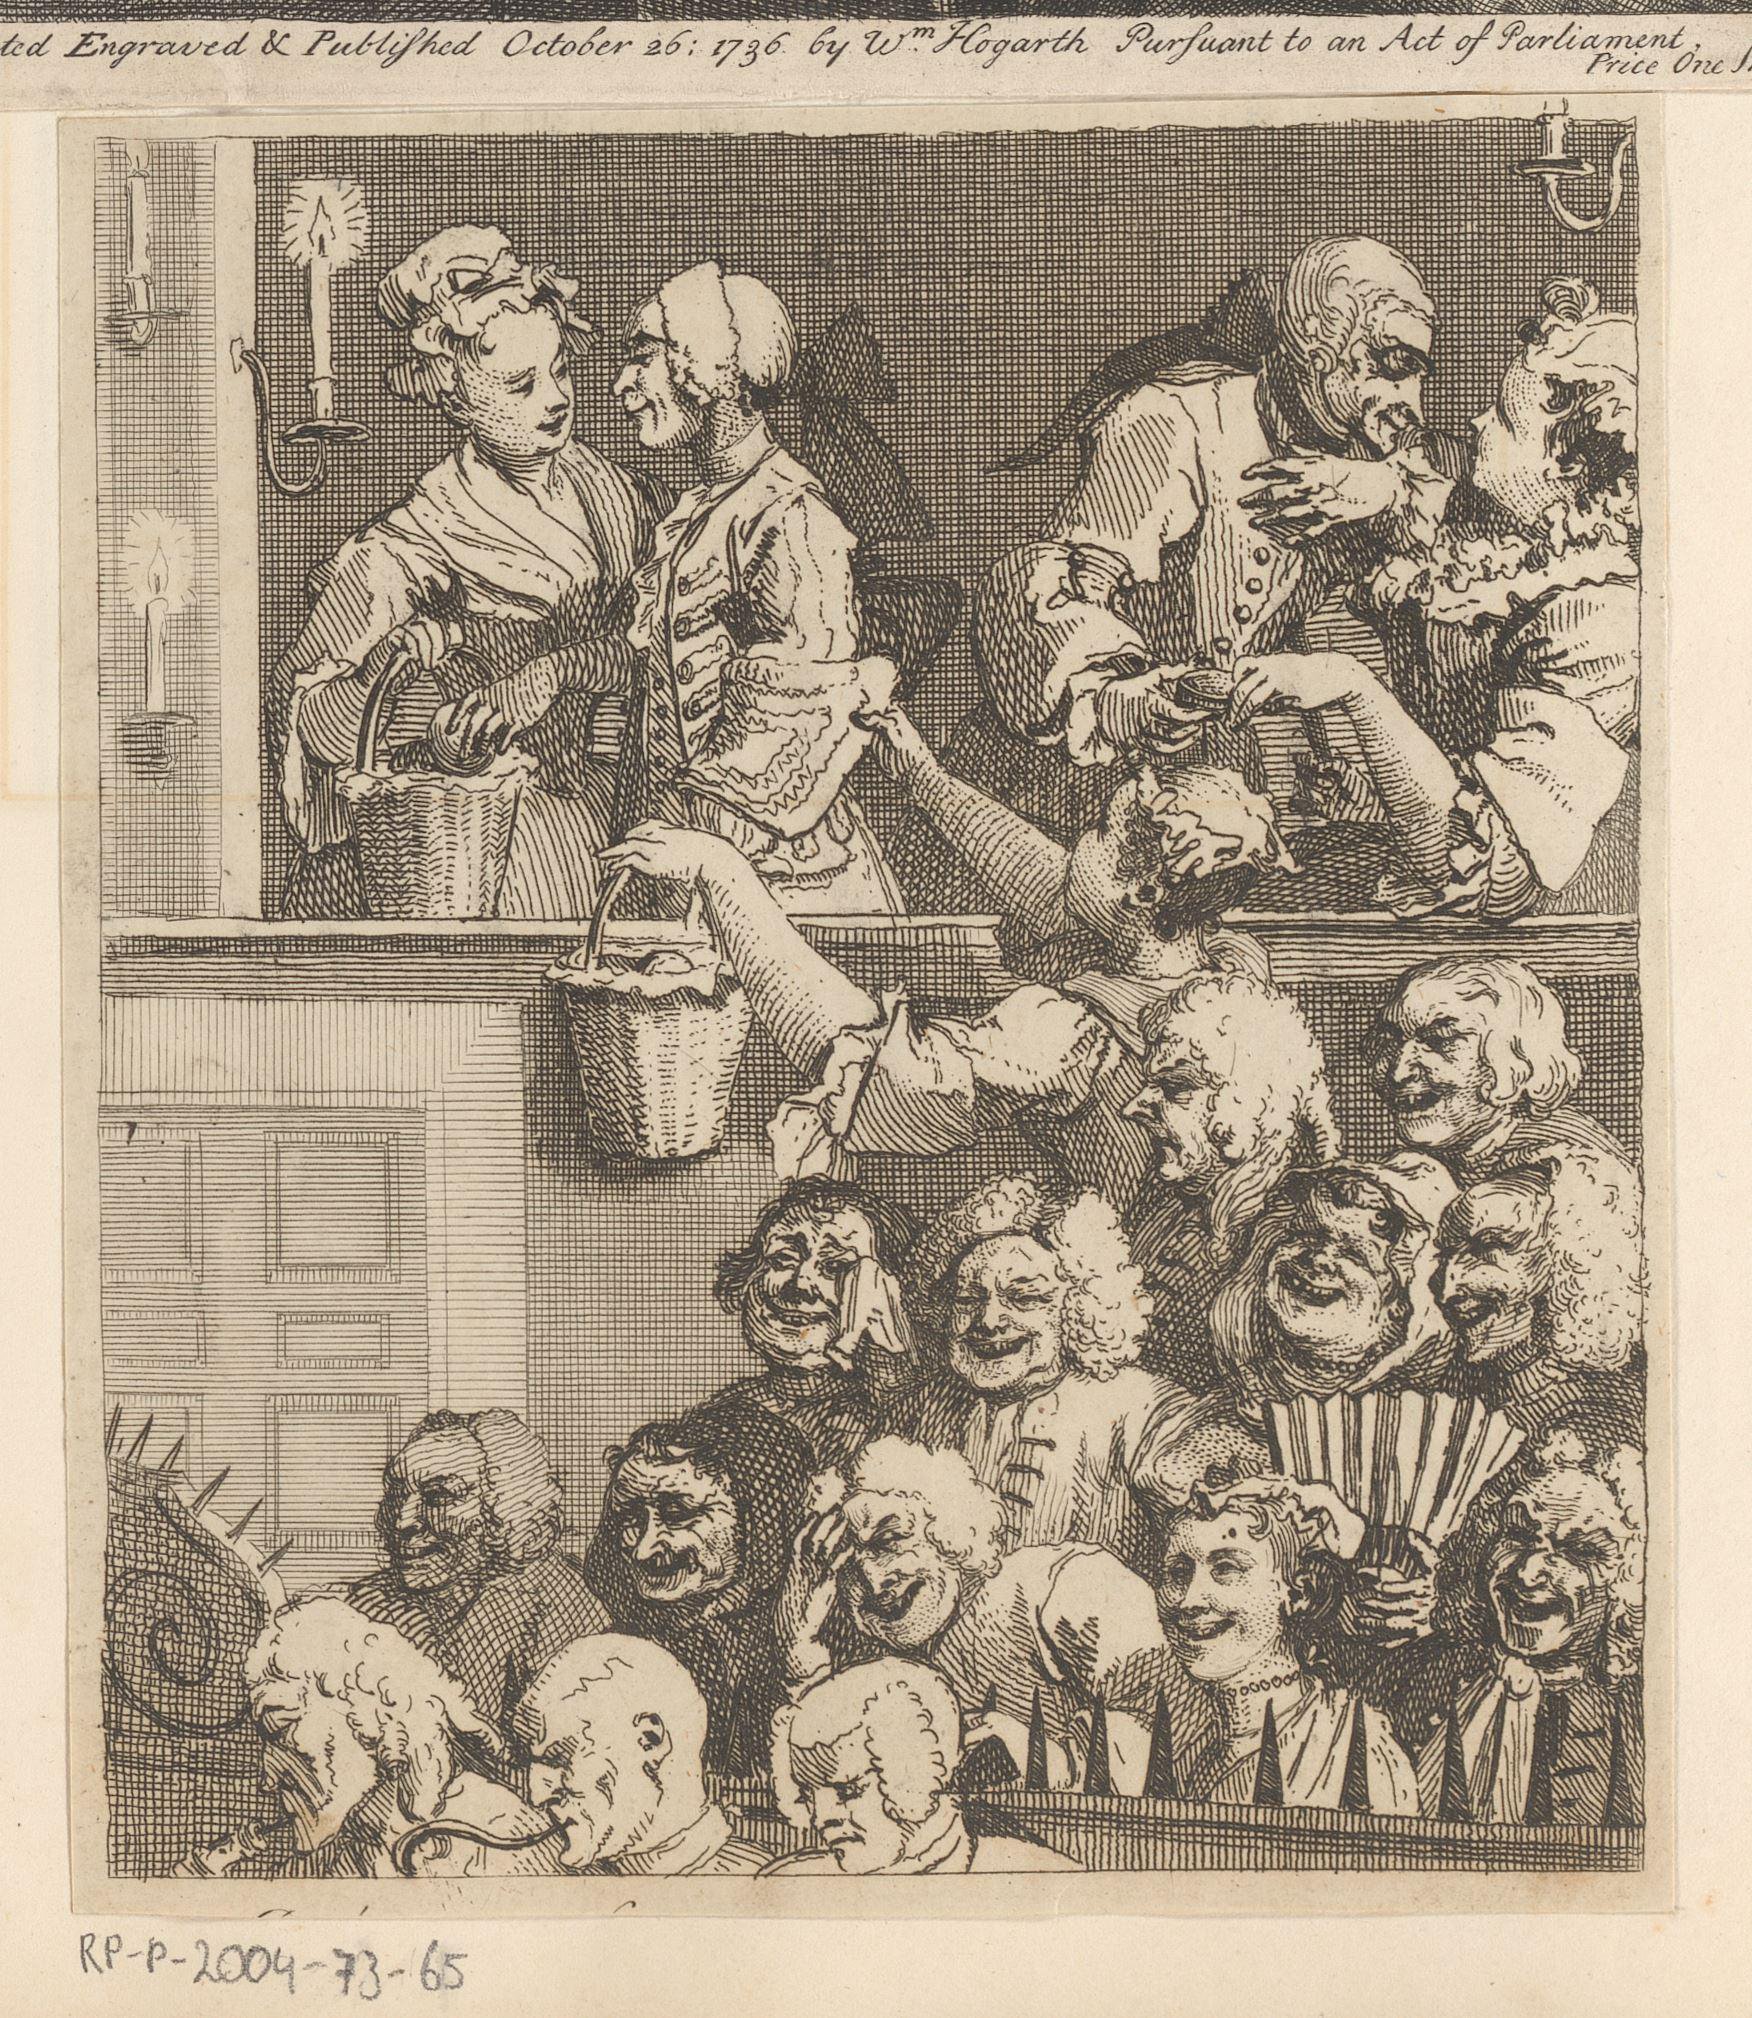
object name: print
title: The Laughing Audience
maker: william hogarth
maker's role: draughtsman, painter, print maker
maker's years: 1697-1764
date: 1733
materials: paper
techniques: etching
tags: laughing, social stratification, social groups, the audience ~ art performance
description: De samensteller heeft deze prent in het album geplakt als illustratie bij: Pilkington, Matthew en Johann Heinrich Füssli. A dictionary of painters, from the revival of the art to the present period. 4 dln. Londen: John Crowder, 1805, dl. 2, p. 252.